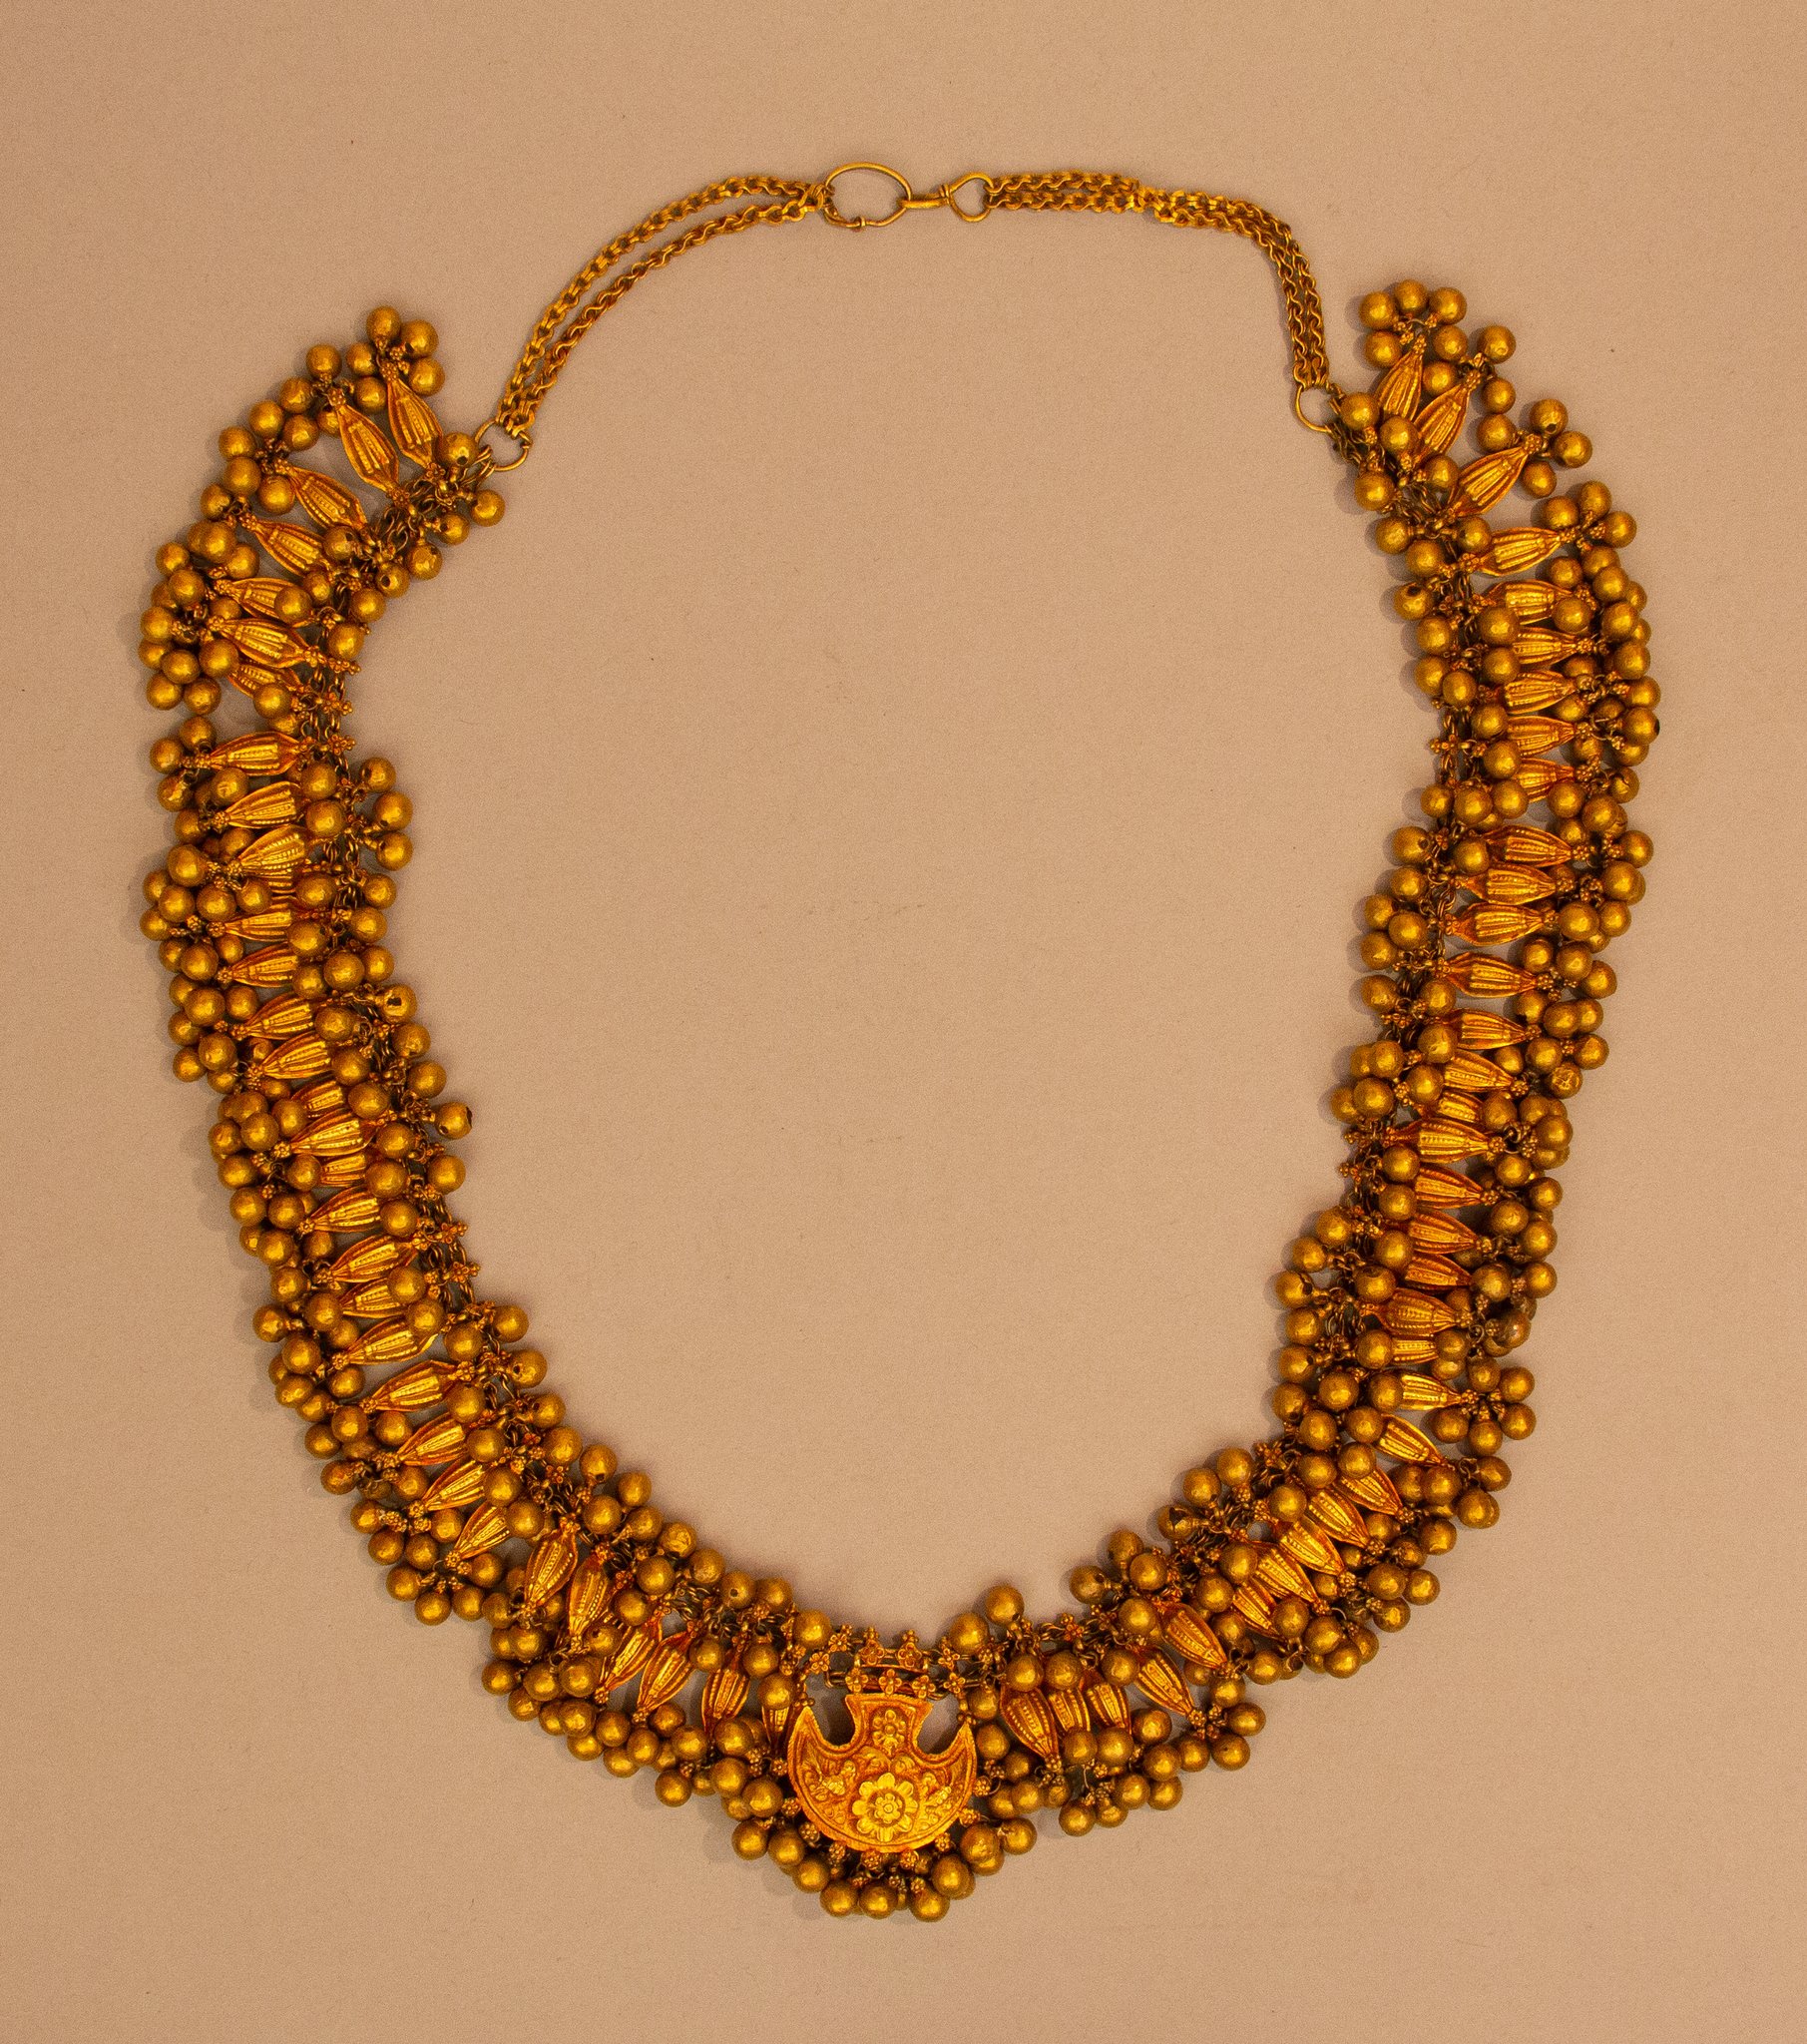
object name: necklace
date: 1701-1900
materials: gold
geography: india